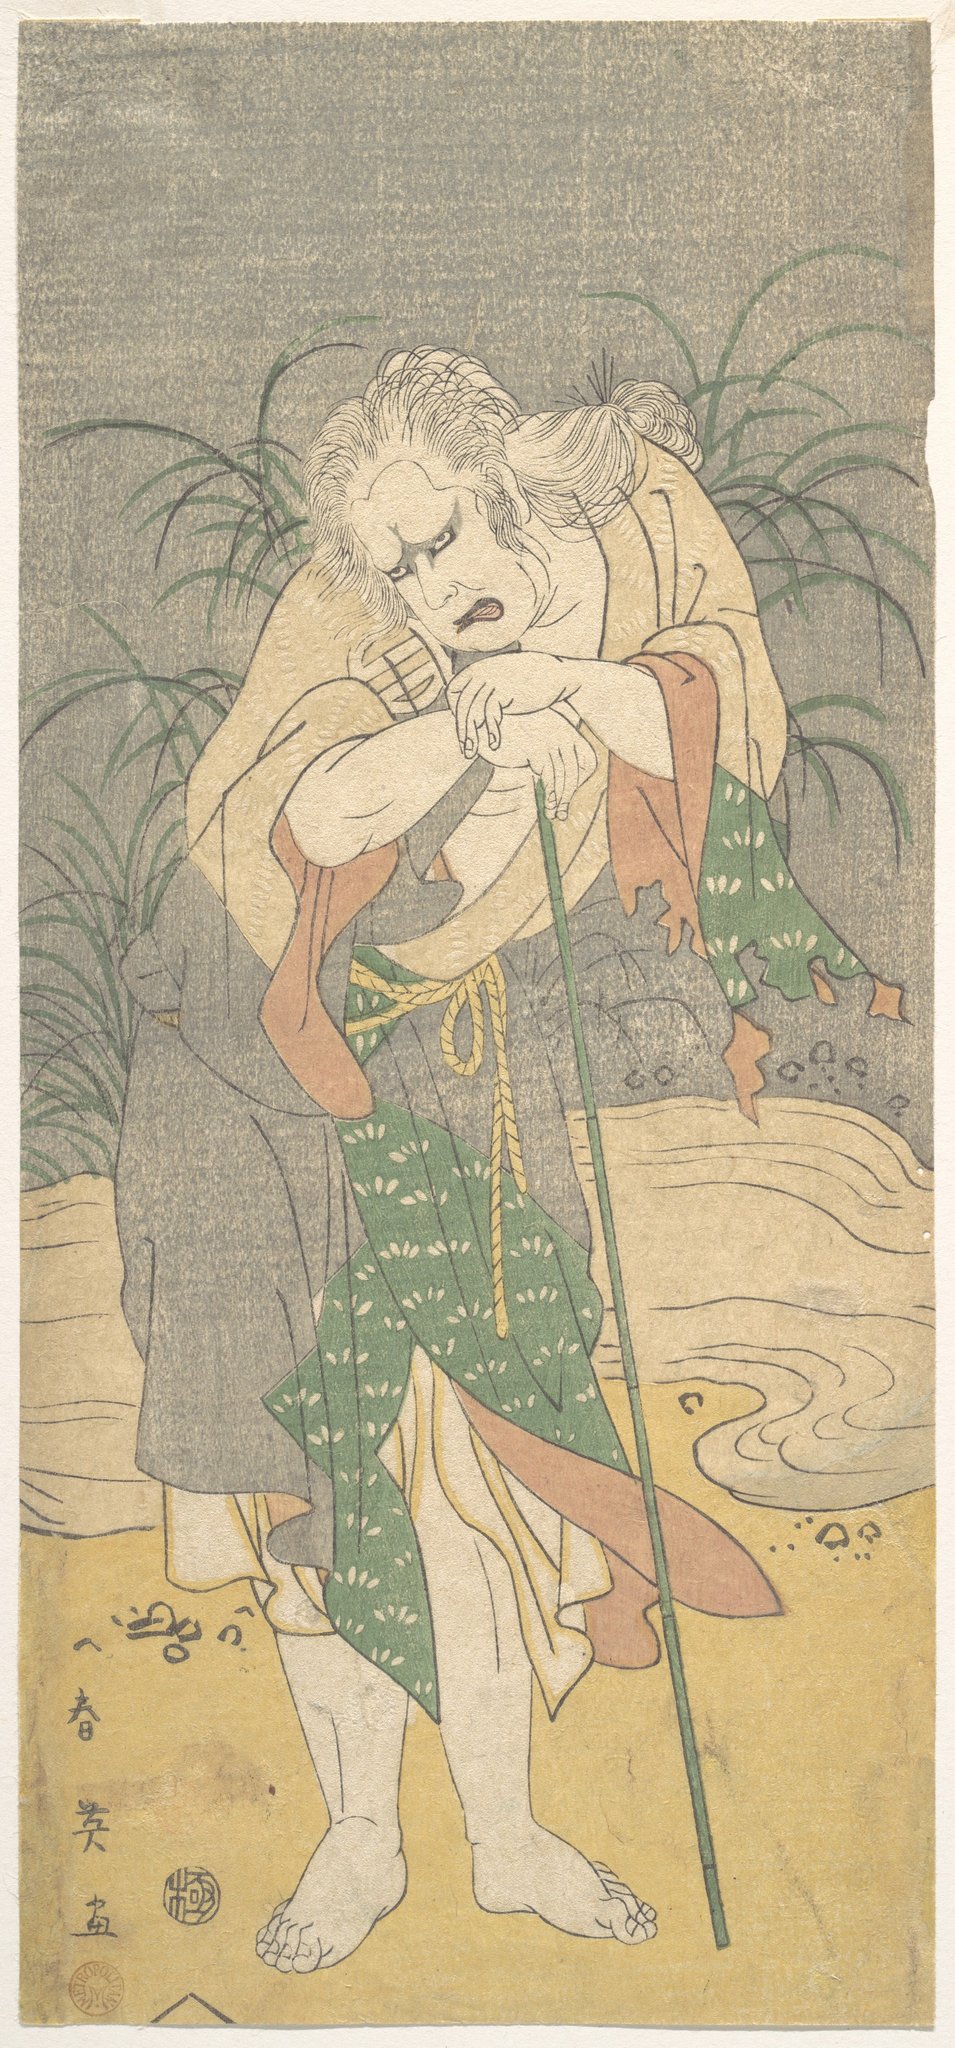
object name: woodblock print nishiki e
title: The Actor Kataoka Nizaemon VII as the Old Beggar Woman Kurozuka Babā at Adachigahara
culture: japanese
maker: katsukawa shun'ei 勝川春英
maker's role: artist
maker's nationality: japanese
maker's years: 1762-1819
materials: ink, paper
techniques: nishiki e, woodblock print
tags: women,actors